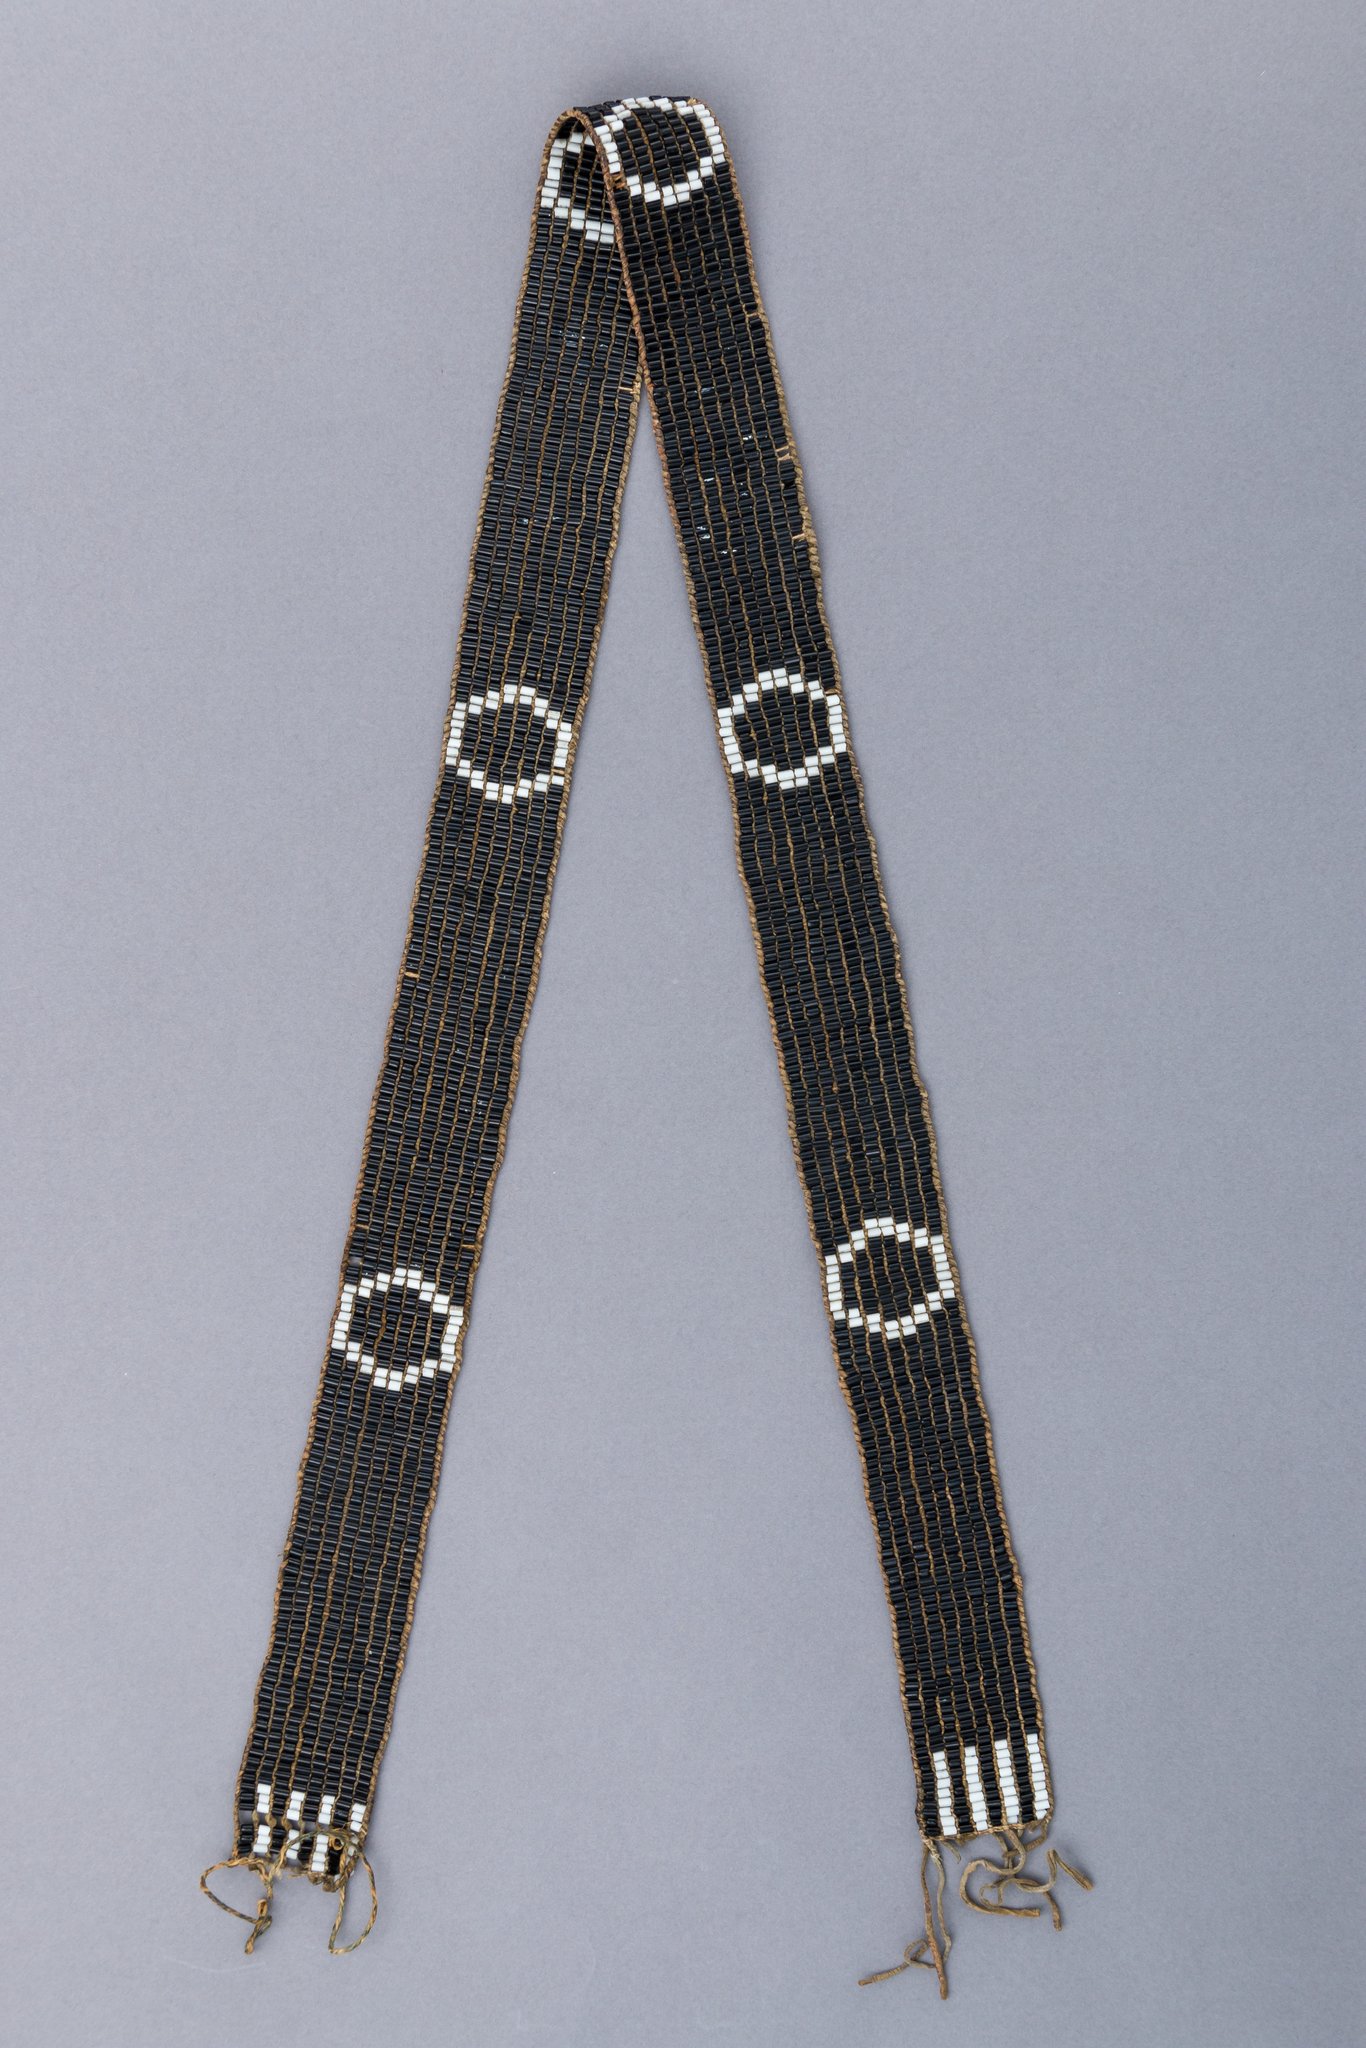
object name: shoulder belt for a powder horn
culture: european or native american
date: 1801-1833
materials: glass, leather